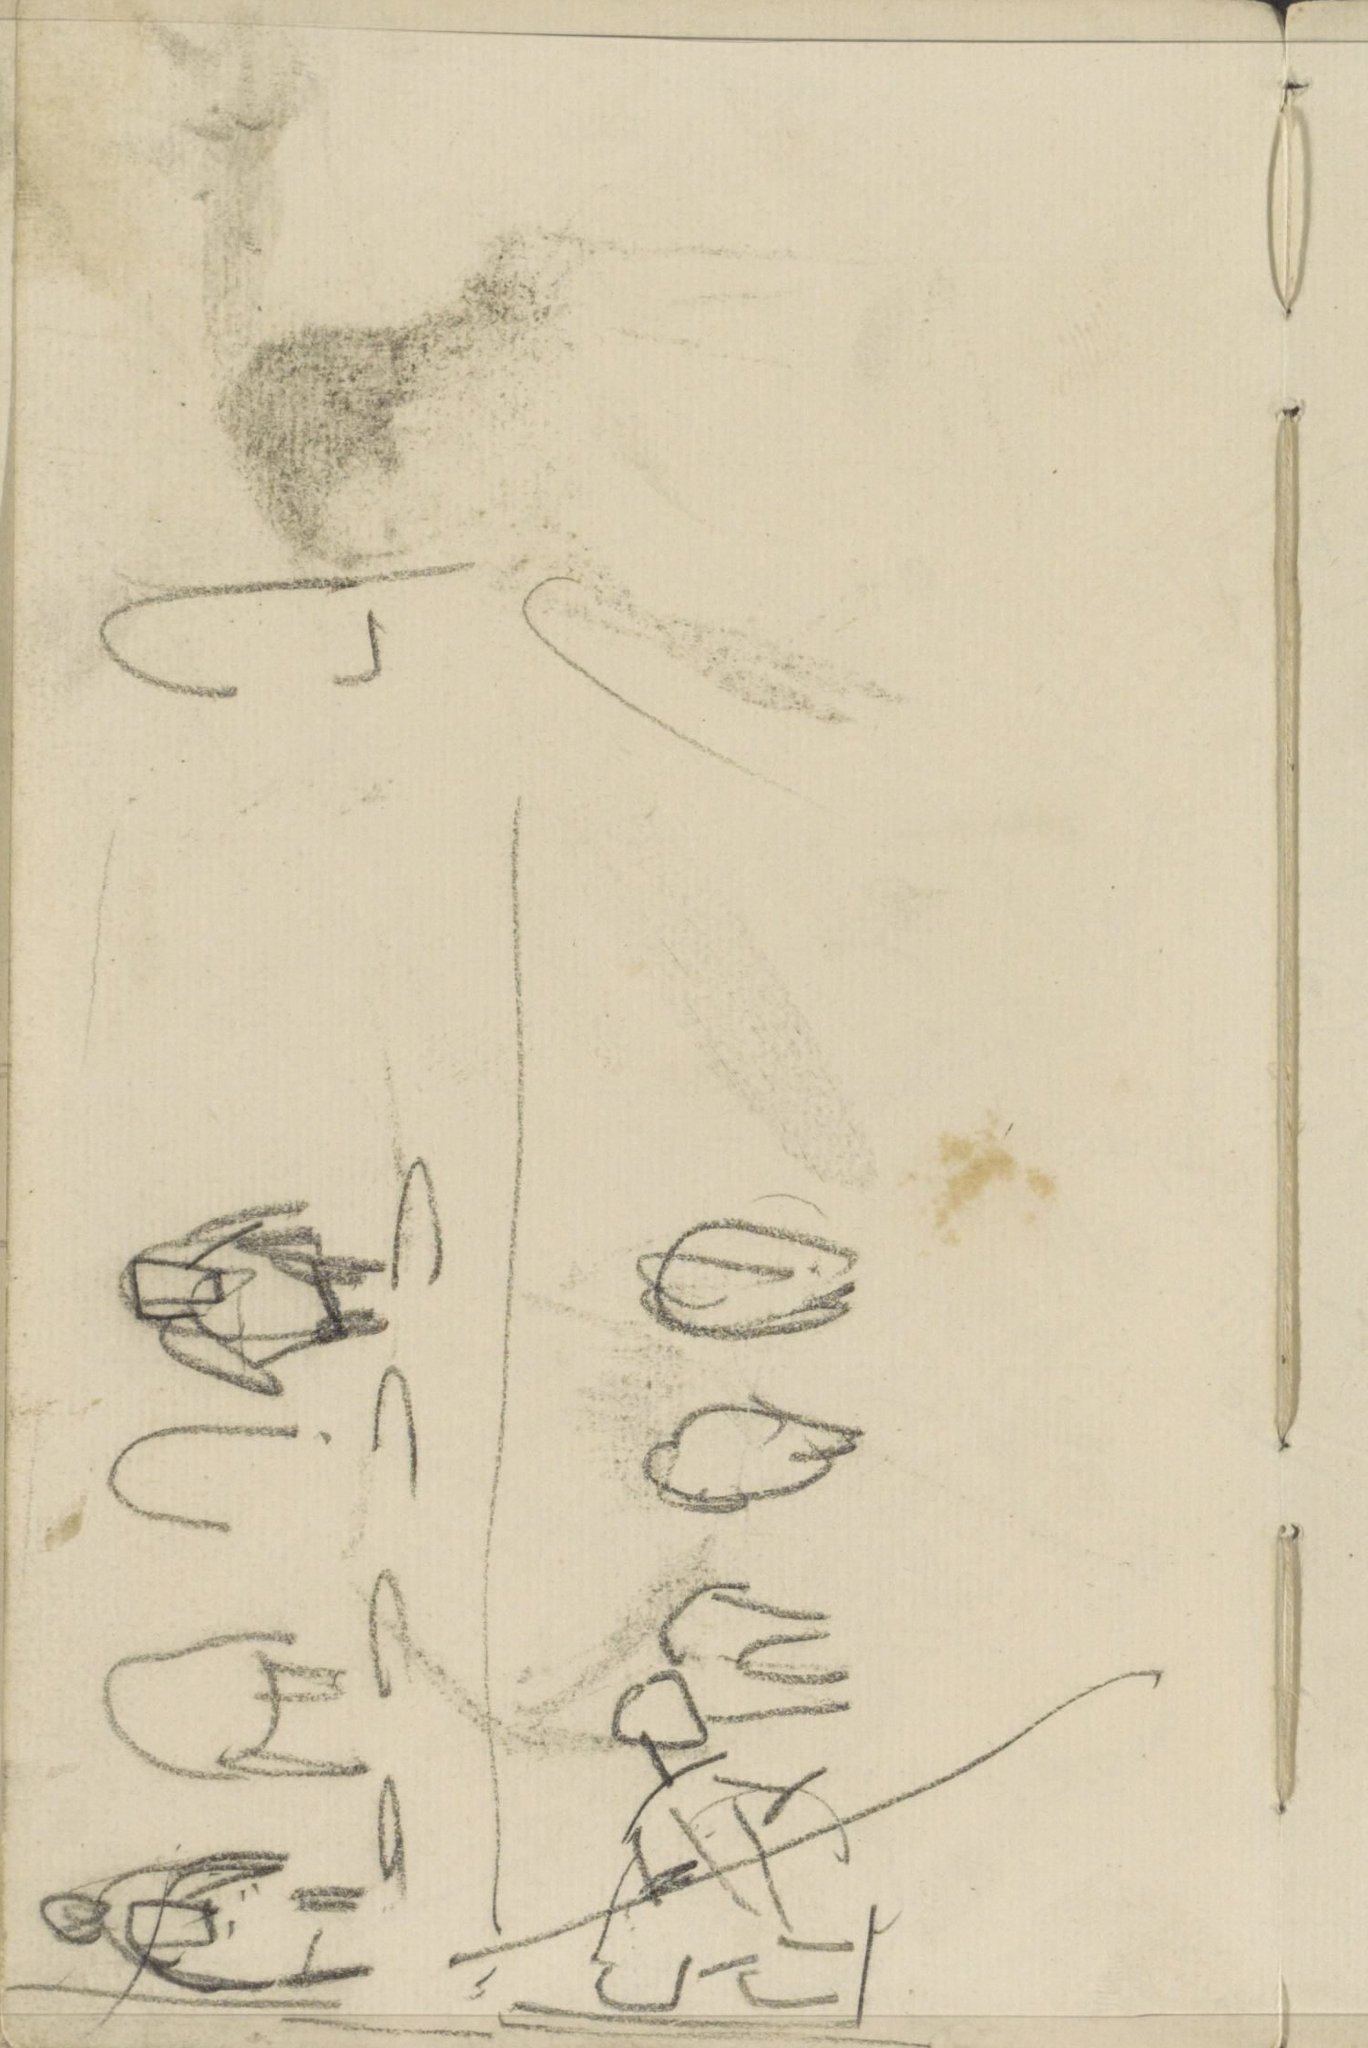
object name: sketchbook leaf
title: Studieblad, mogelijk met figuren en honden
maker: george hendrik breitner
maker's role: draughtsman, painter, print maker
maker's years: 1857-1923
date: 1881-1883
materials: chalk, paper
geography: the hague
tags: adult woman, adult man, dog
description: Blad 5 verso uit een schetsboek met 9 bladen.